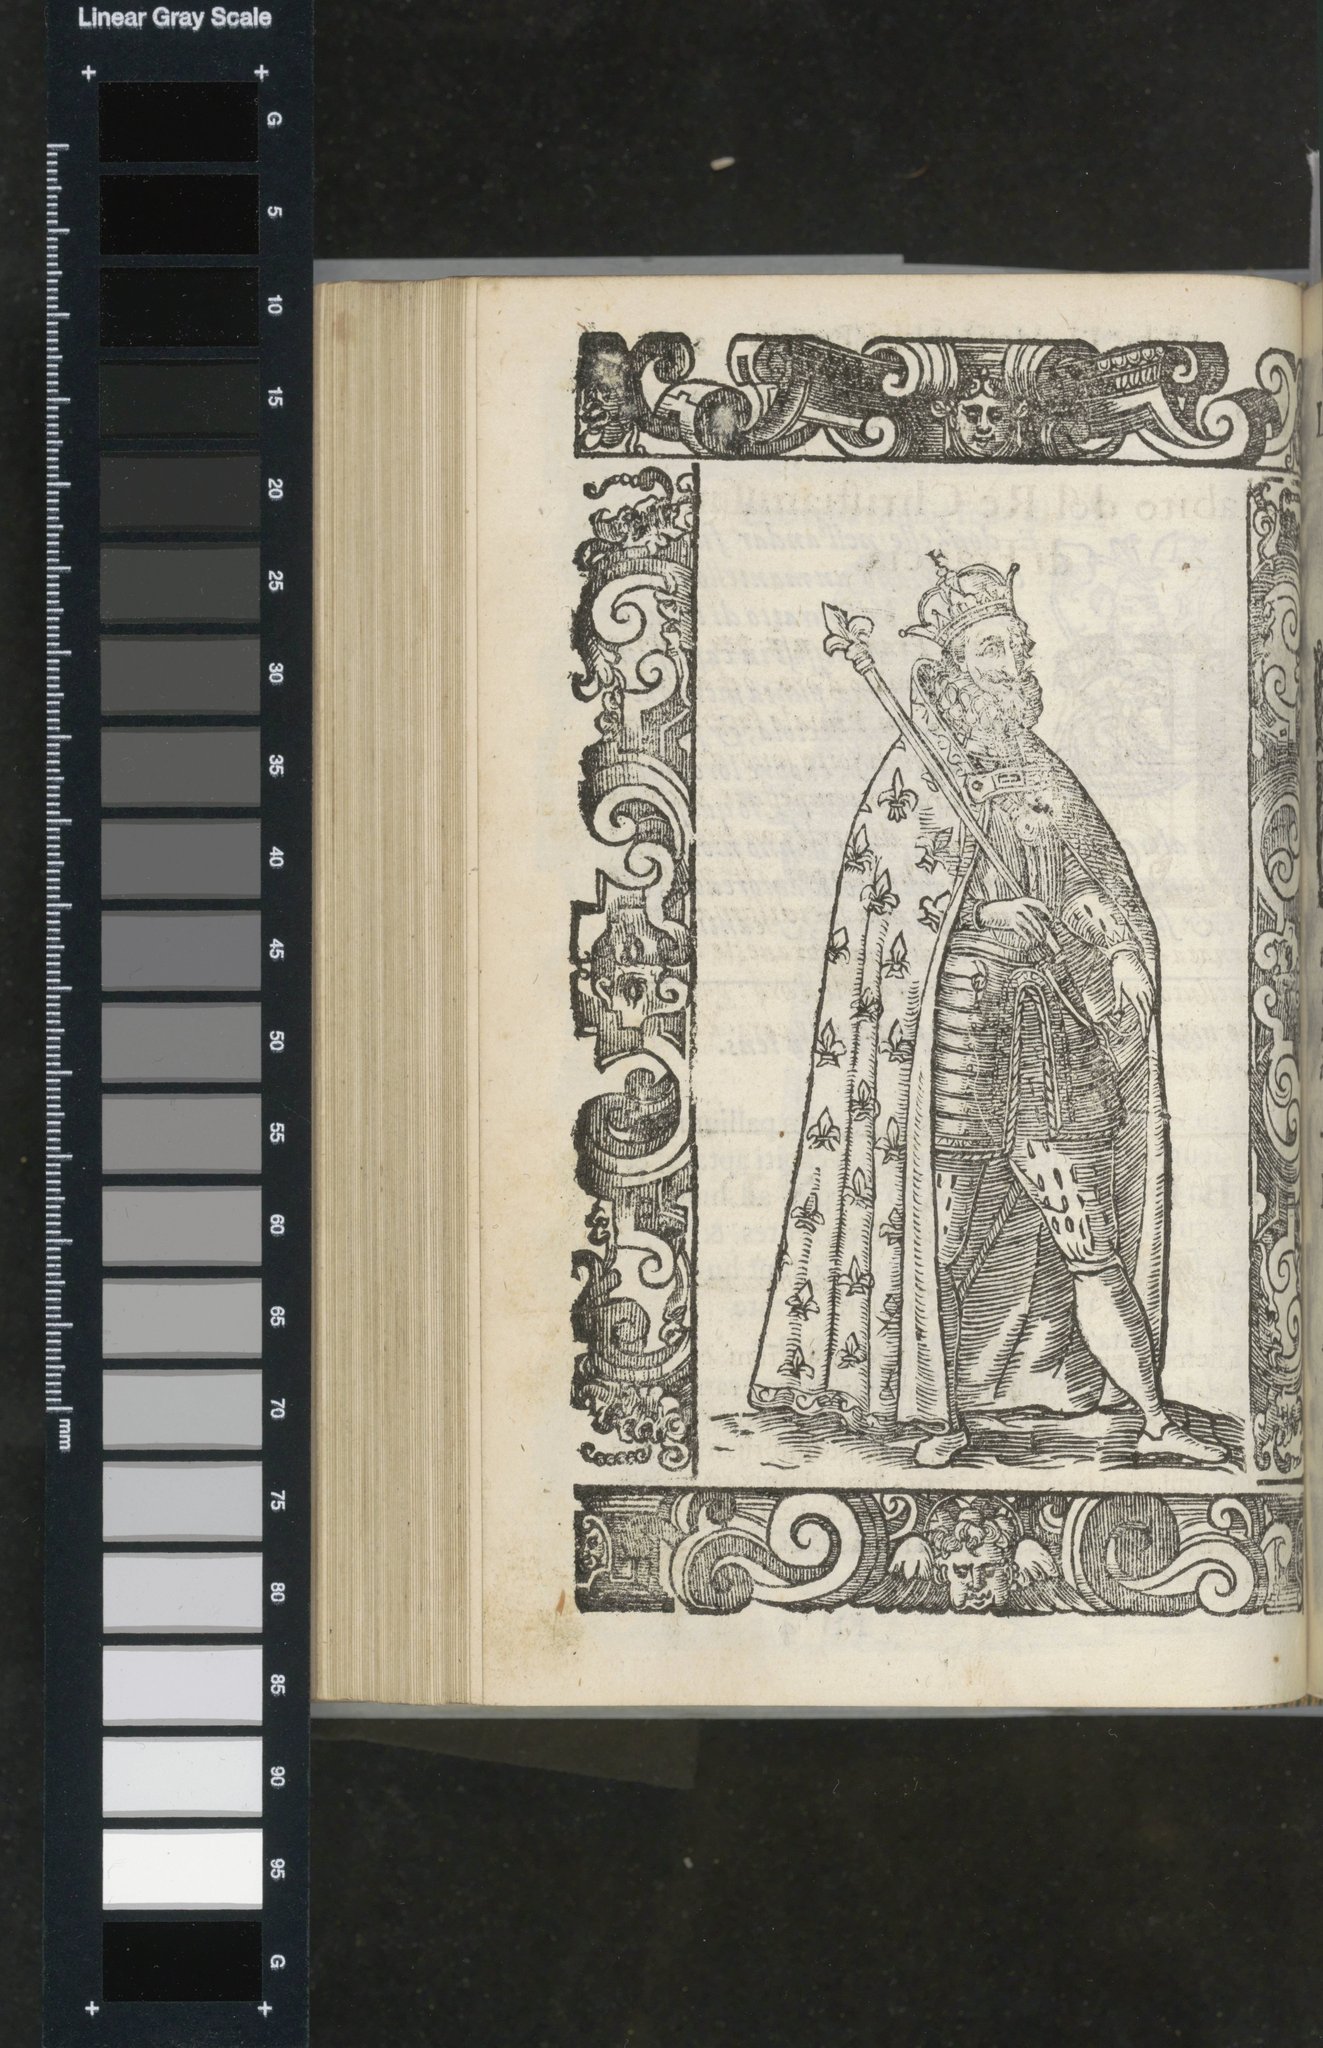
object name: costume print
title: Habiti antichi, et moderni di tutto il mondo...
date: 1598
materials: paper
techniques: woodcut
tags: fashion plates